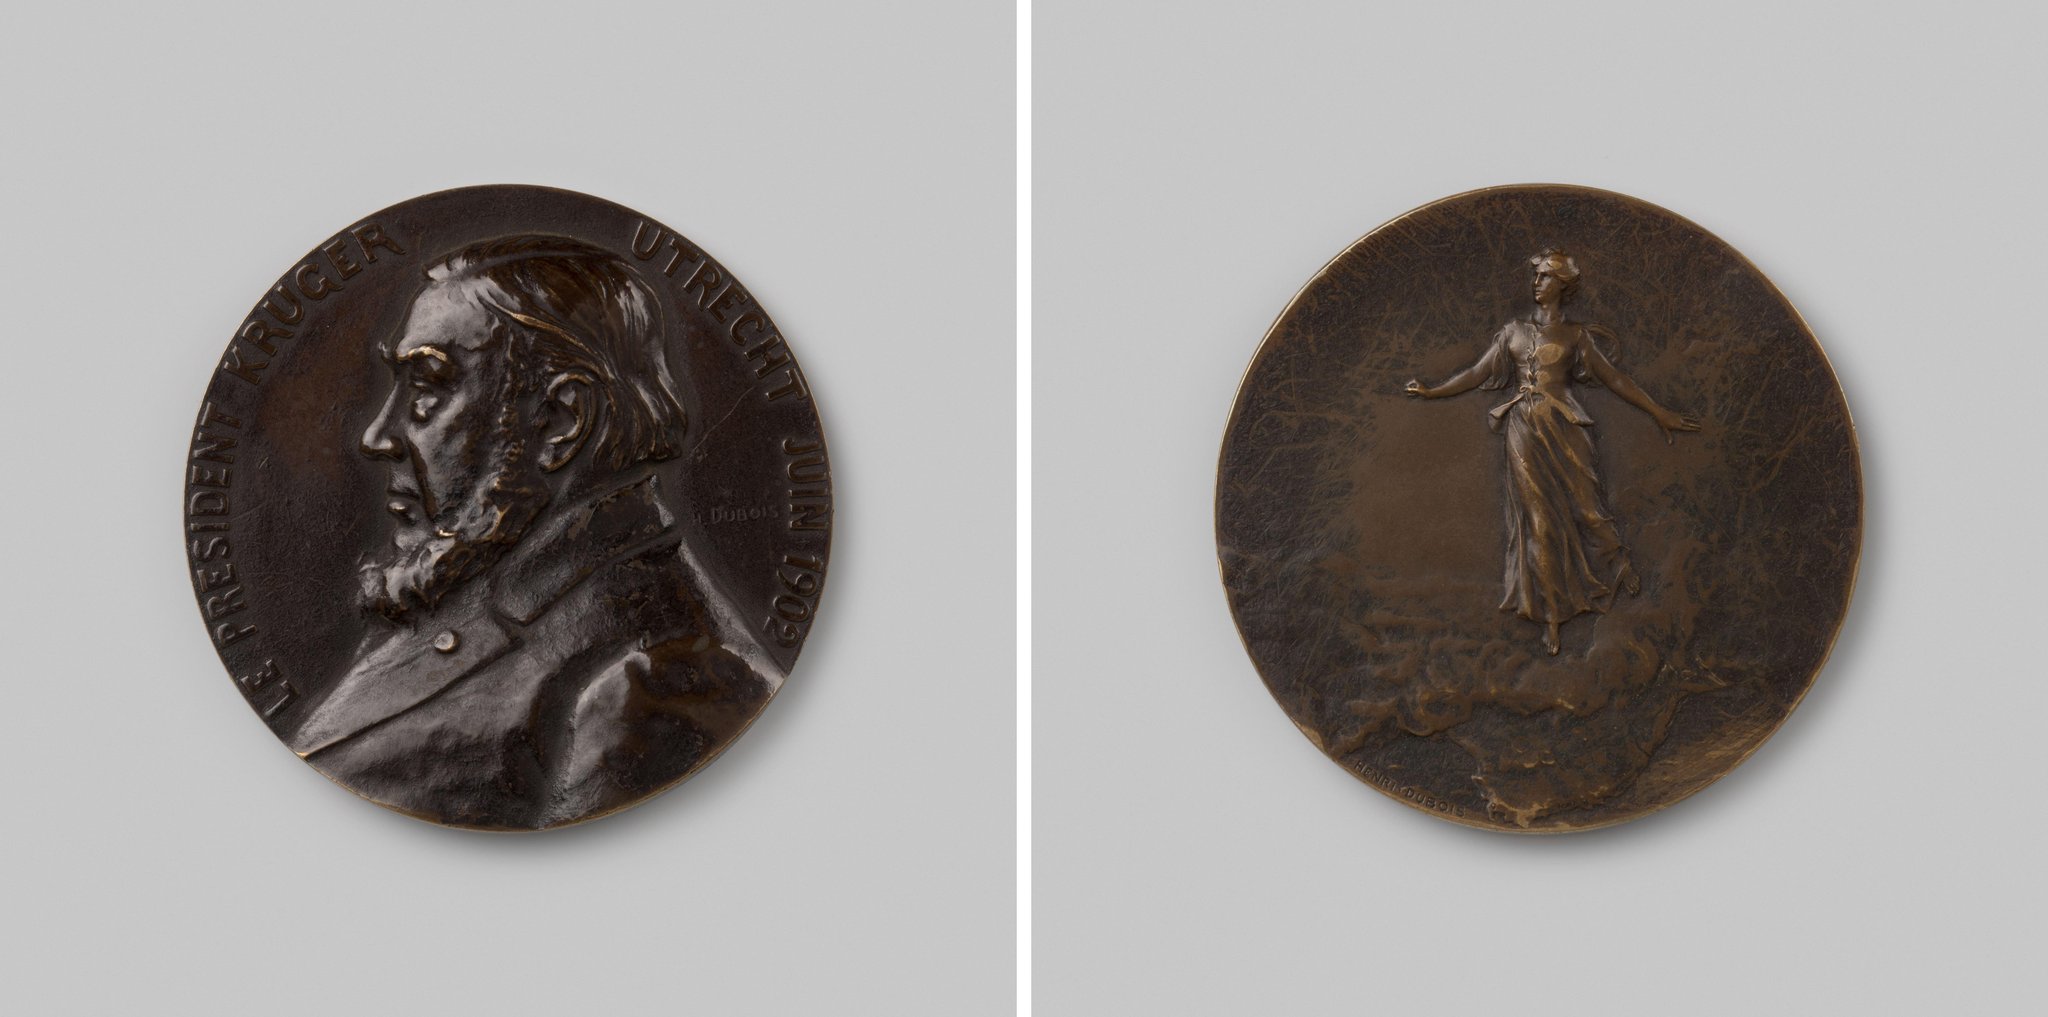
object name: history medal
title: Verblijf van Paul Kruger, president van de republiek Zuid-Afrika, te Utrecht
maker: henri alfred auguste dubois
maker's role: sculptor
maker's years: 1859-1914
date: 1902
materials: bronze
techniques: striking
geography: france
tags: utrecht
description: Bronzen penning. Voorzijde: borststuk man binnen omschrift. Keerzijde: vrouwefiguur, lopend over wolken, die grootste deel van werelddeel Afrika bedekken, maar zuidelijke punt vrijlaten; links boven: zonnestralen. Met bijbehorende doos NG-709-11-2.